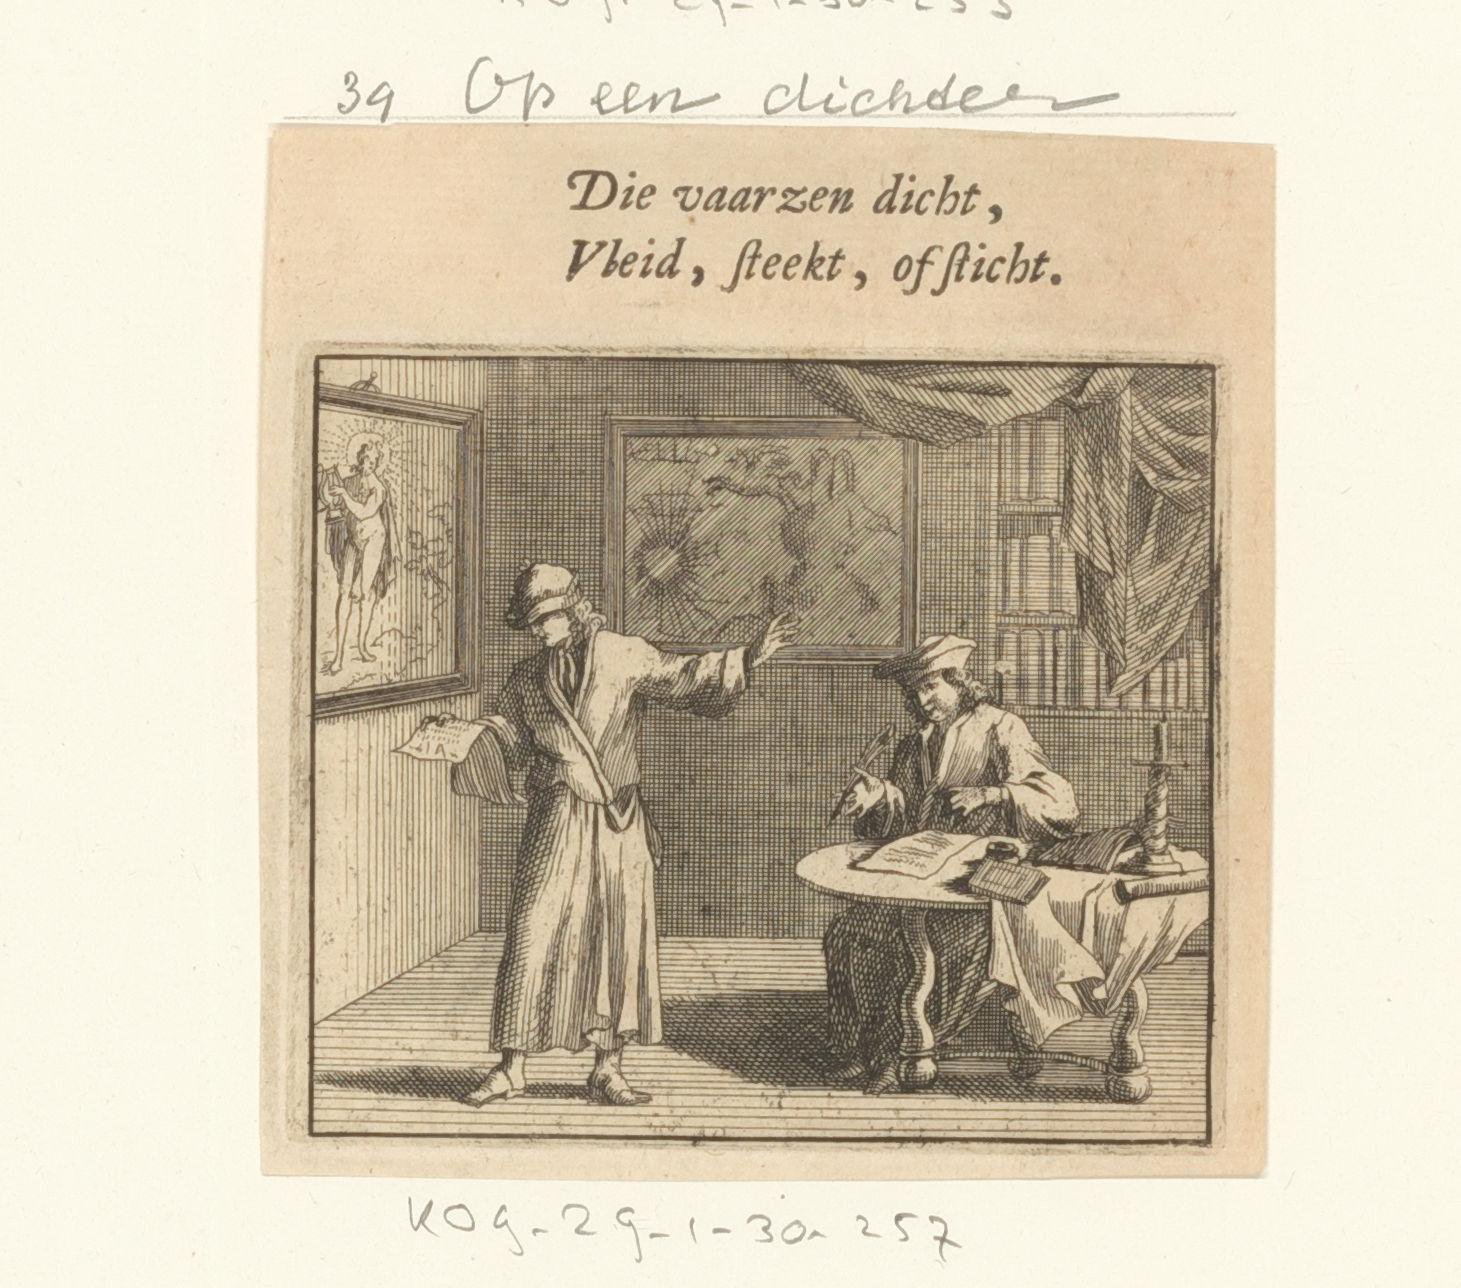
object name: print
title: Die vaarzen dicht, Vleid, steekt, of sticht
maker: cornelis huyberts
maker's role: print maker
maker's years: 1669-1709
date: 1725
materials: paper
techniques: etching, letterpress printing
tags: author, poet dictating, autograph ~ author, poet, author, poet writing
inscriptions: stamp, collector's mark: Lugt 1641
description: Prent uit: Graauwhart, Hendrik. Voorbeeldelyke zeede-lessen, genoomen uyt den eersten toestand des werelds (...). Amsterdam: Johannes Ratelband, 1725. Prent ook gebruikt voor eerdere en (1709) latere uitgave (1756, 1761 en 1764).